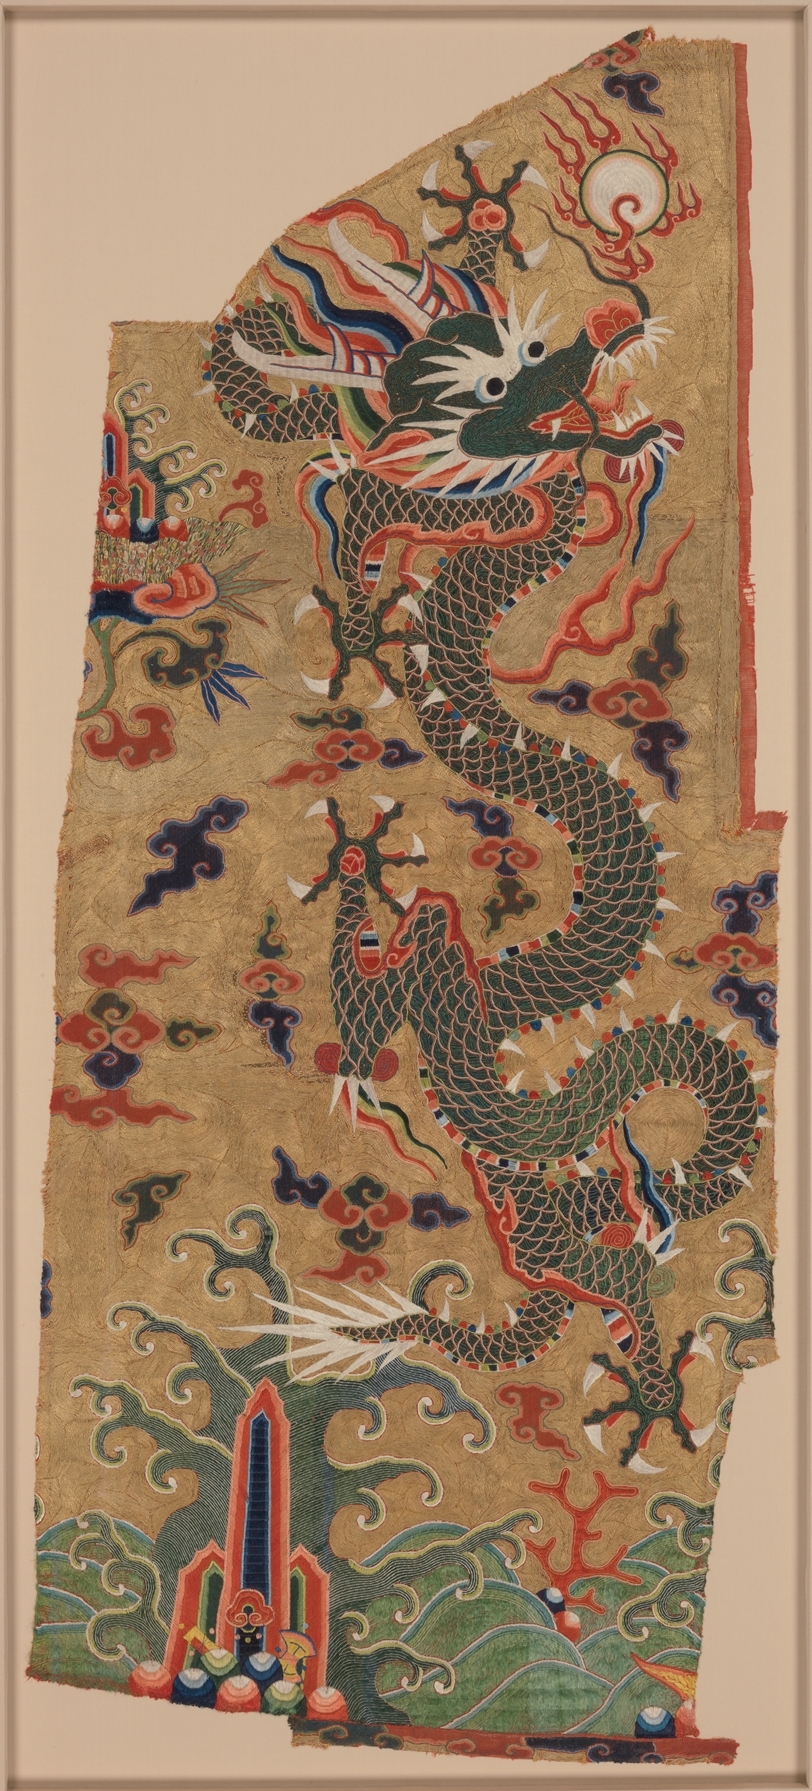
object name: panel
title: Panel with Dragon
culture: chinese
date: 1601-1700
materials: feather, textile, metal thread, silk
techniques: embroidery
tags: dragons